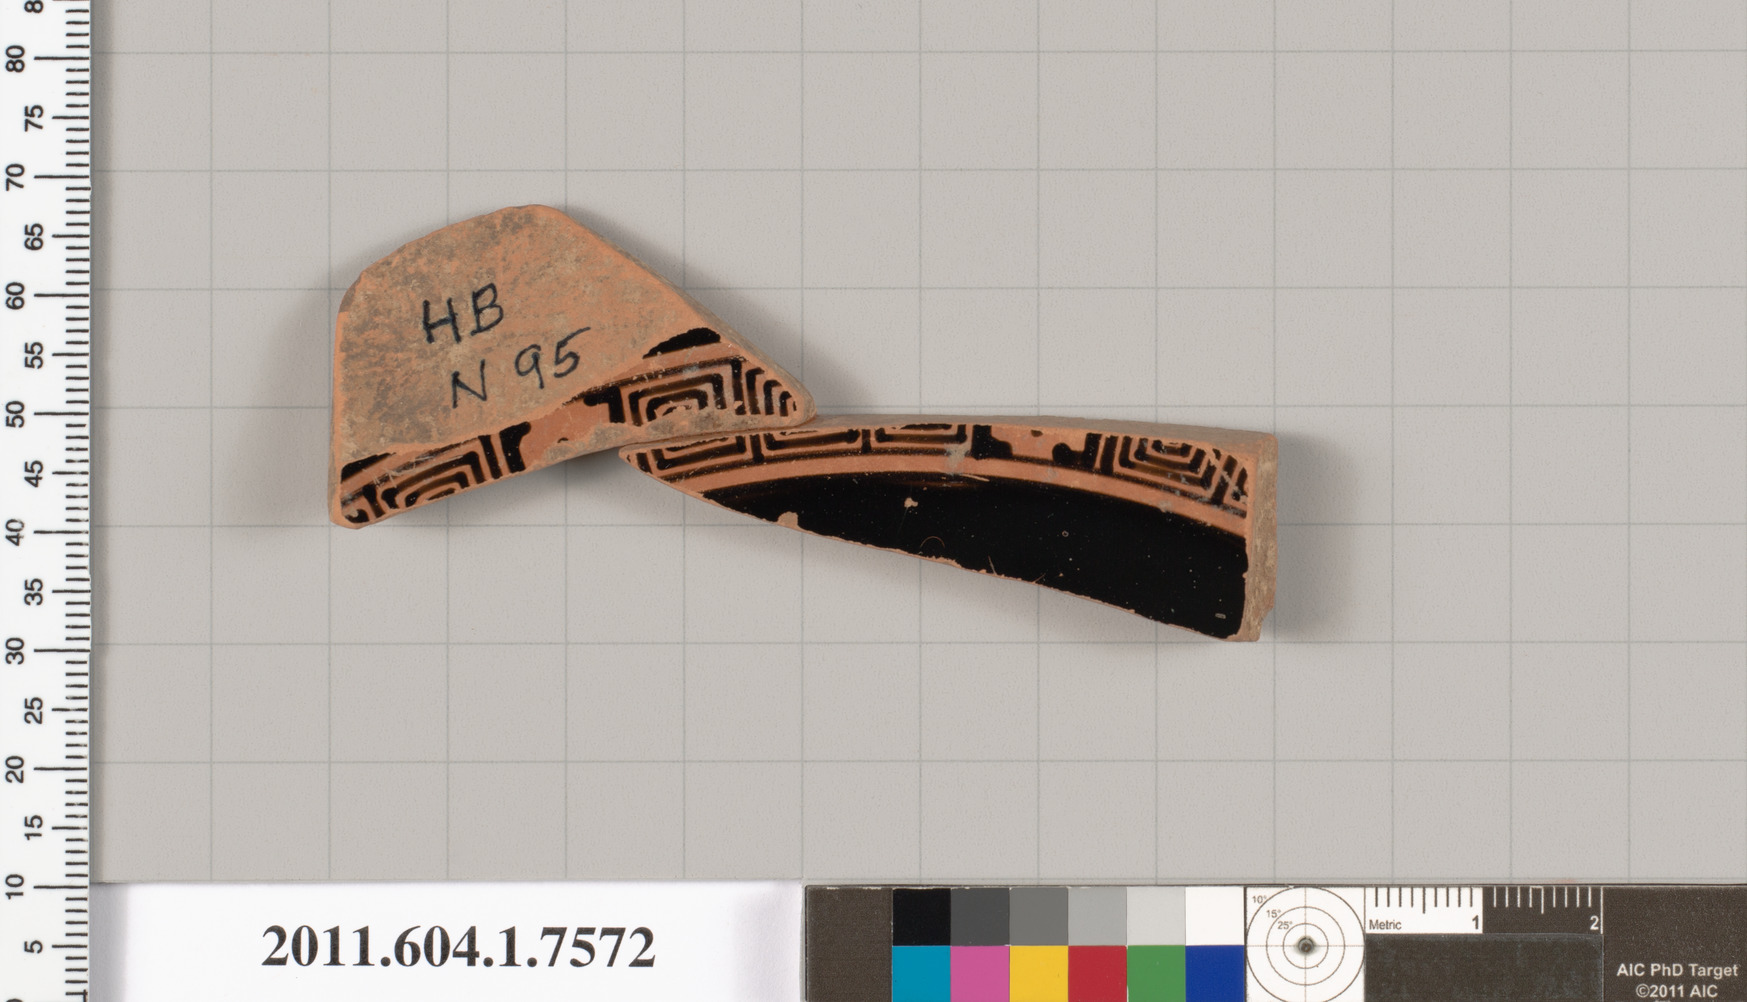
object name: kylix fragment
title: Terracotta fragment of a kylix (drinking cup)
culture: greek, attic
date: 460-450 BCE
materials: terracotta